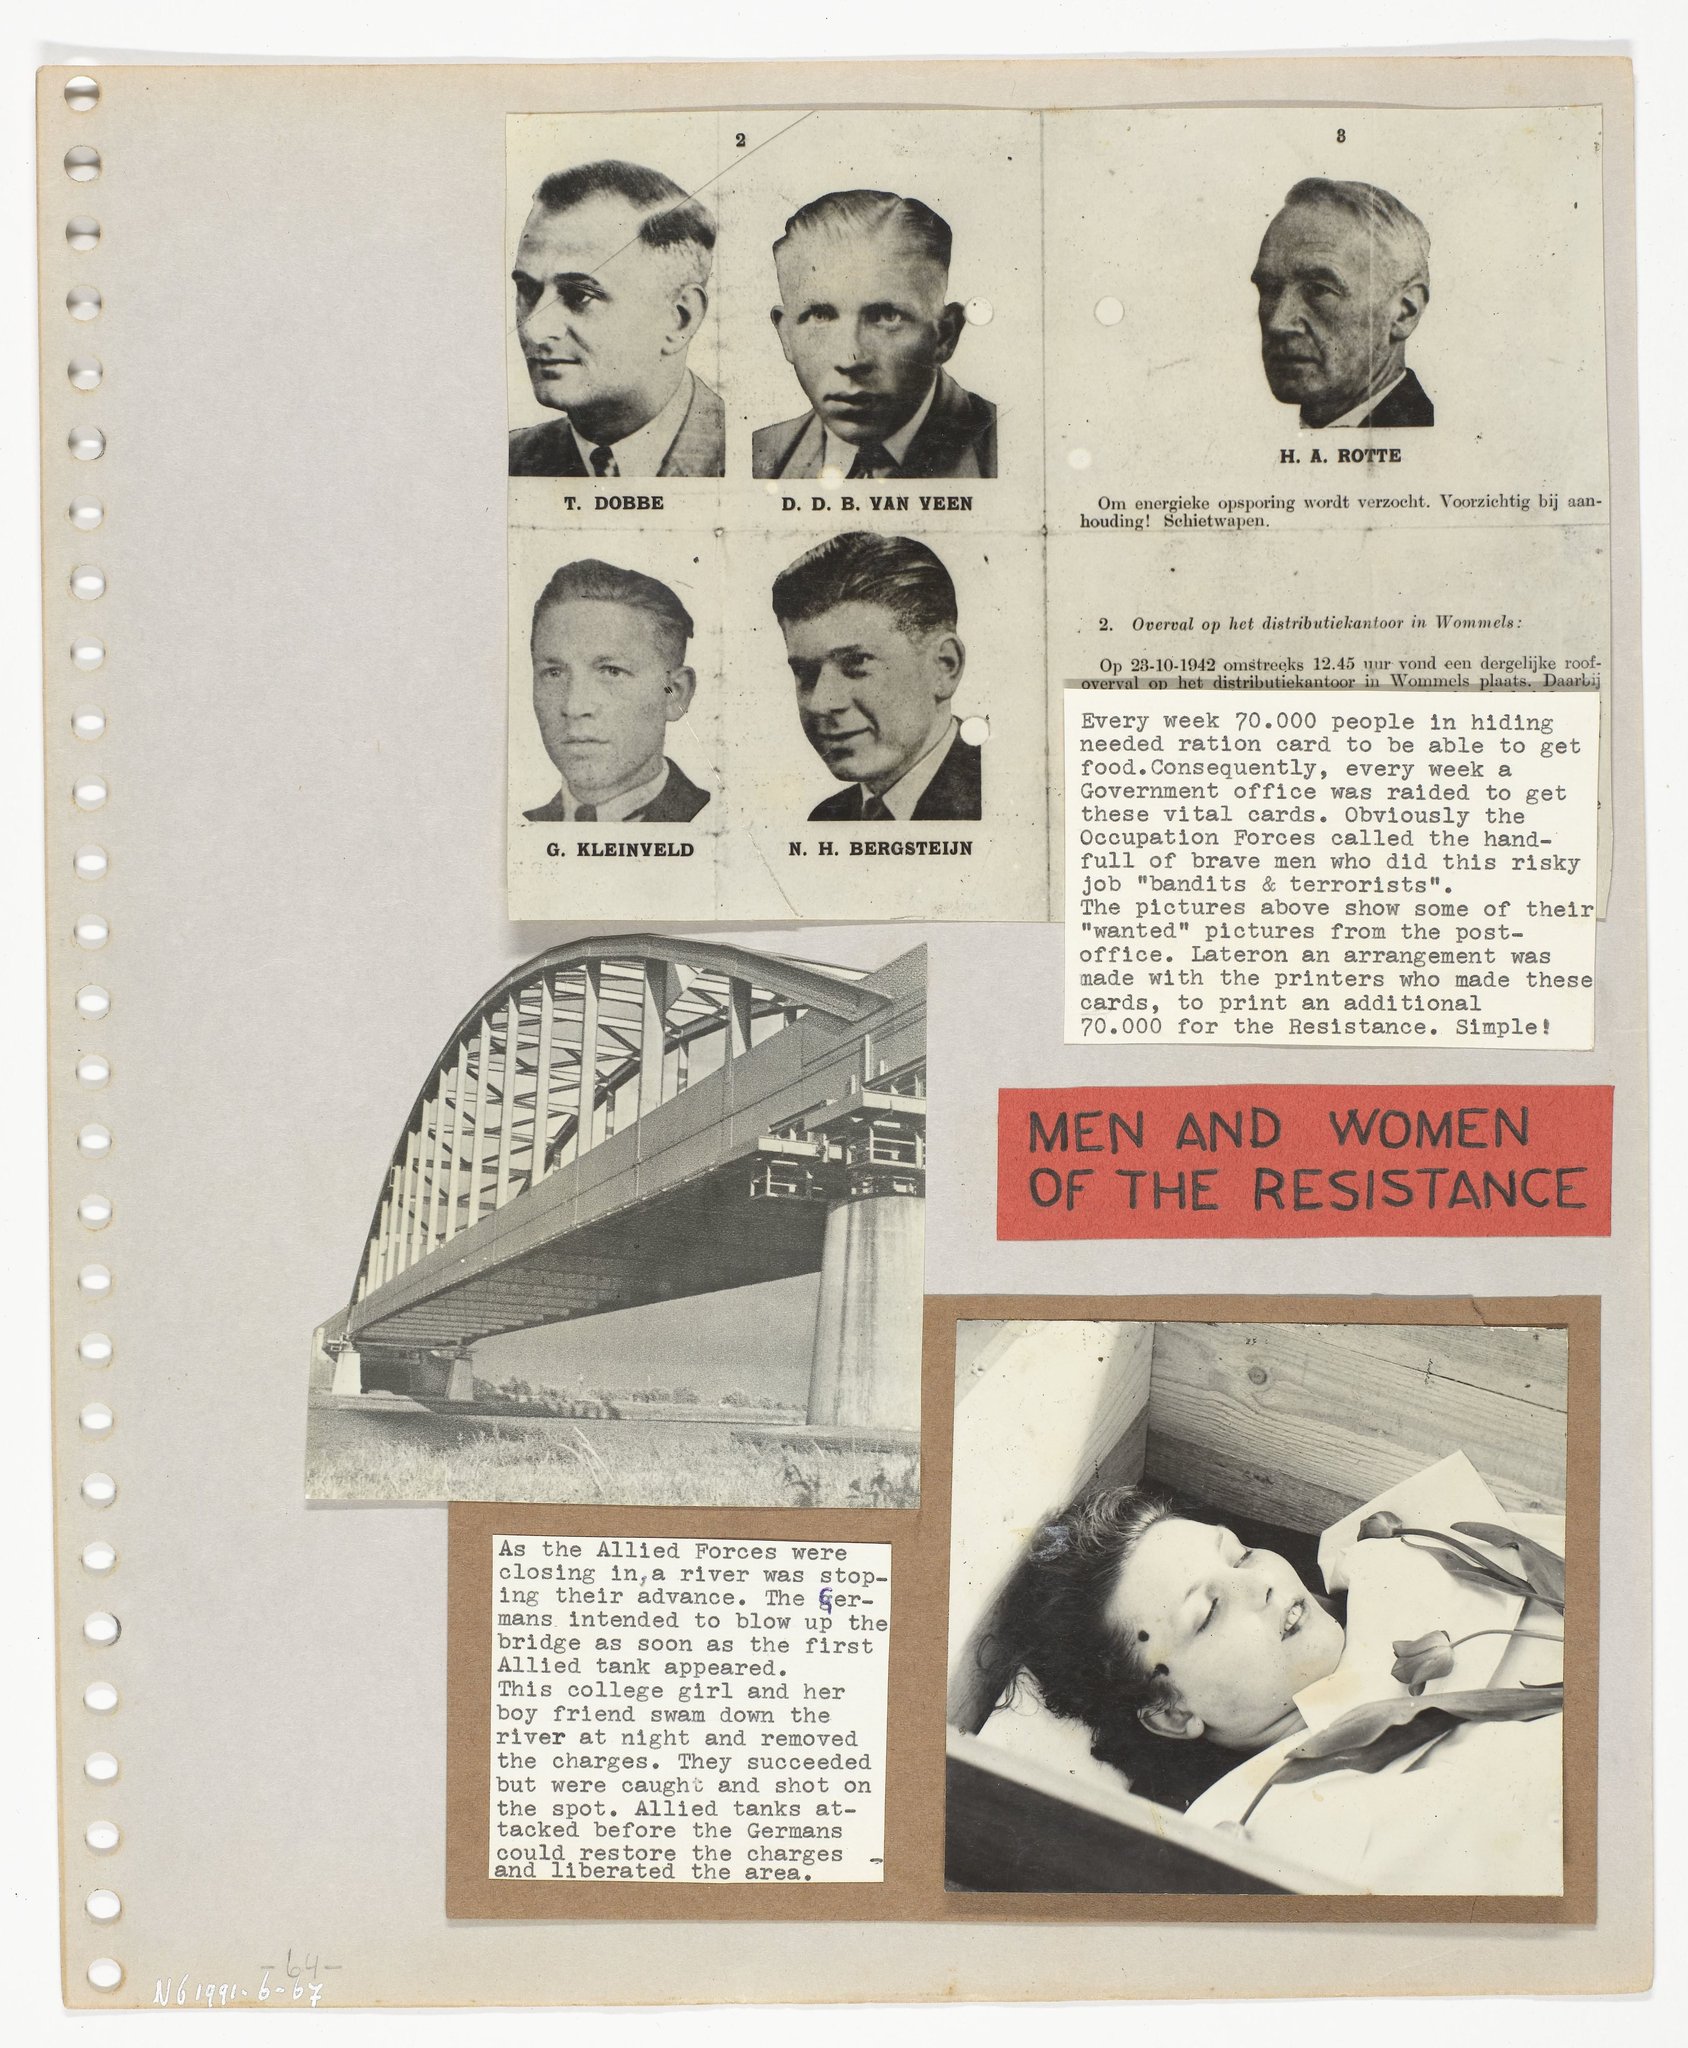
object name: album leaf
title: Mannen en vrouwen van het verzet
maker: Anonymous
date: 1944-1945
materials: paper, plastic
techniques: photography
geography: deventer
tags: amsterdam, tonny van renterghem, fritz kahlenberg, historical persons - bb - woman, underground movement, partisans, historical persons, bridge, netherlands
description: Portretten van 5 mannen gezocht door de Duitsers (foto's boven). Midden en rechts onder: de IJsselbrug die de Duitsers wilden opblazen om de geallieerden de doortocht te belemmeren. Het verzet voorkwam dit. Twee mensen werden gepakt bij het verwijderen van de springstof en doodgeschoten. Rechtsonder de foto van de op 10 april 1945 doodgeschoten vrouw: Cornelia Bos.